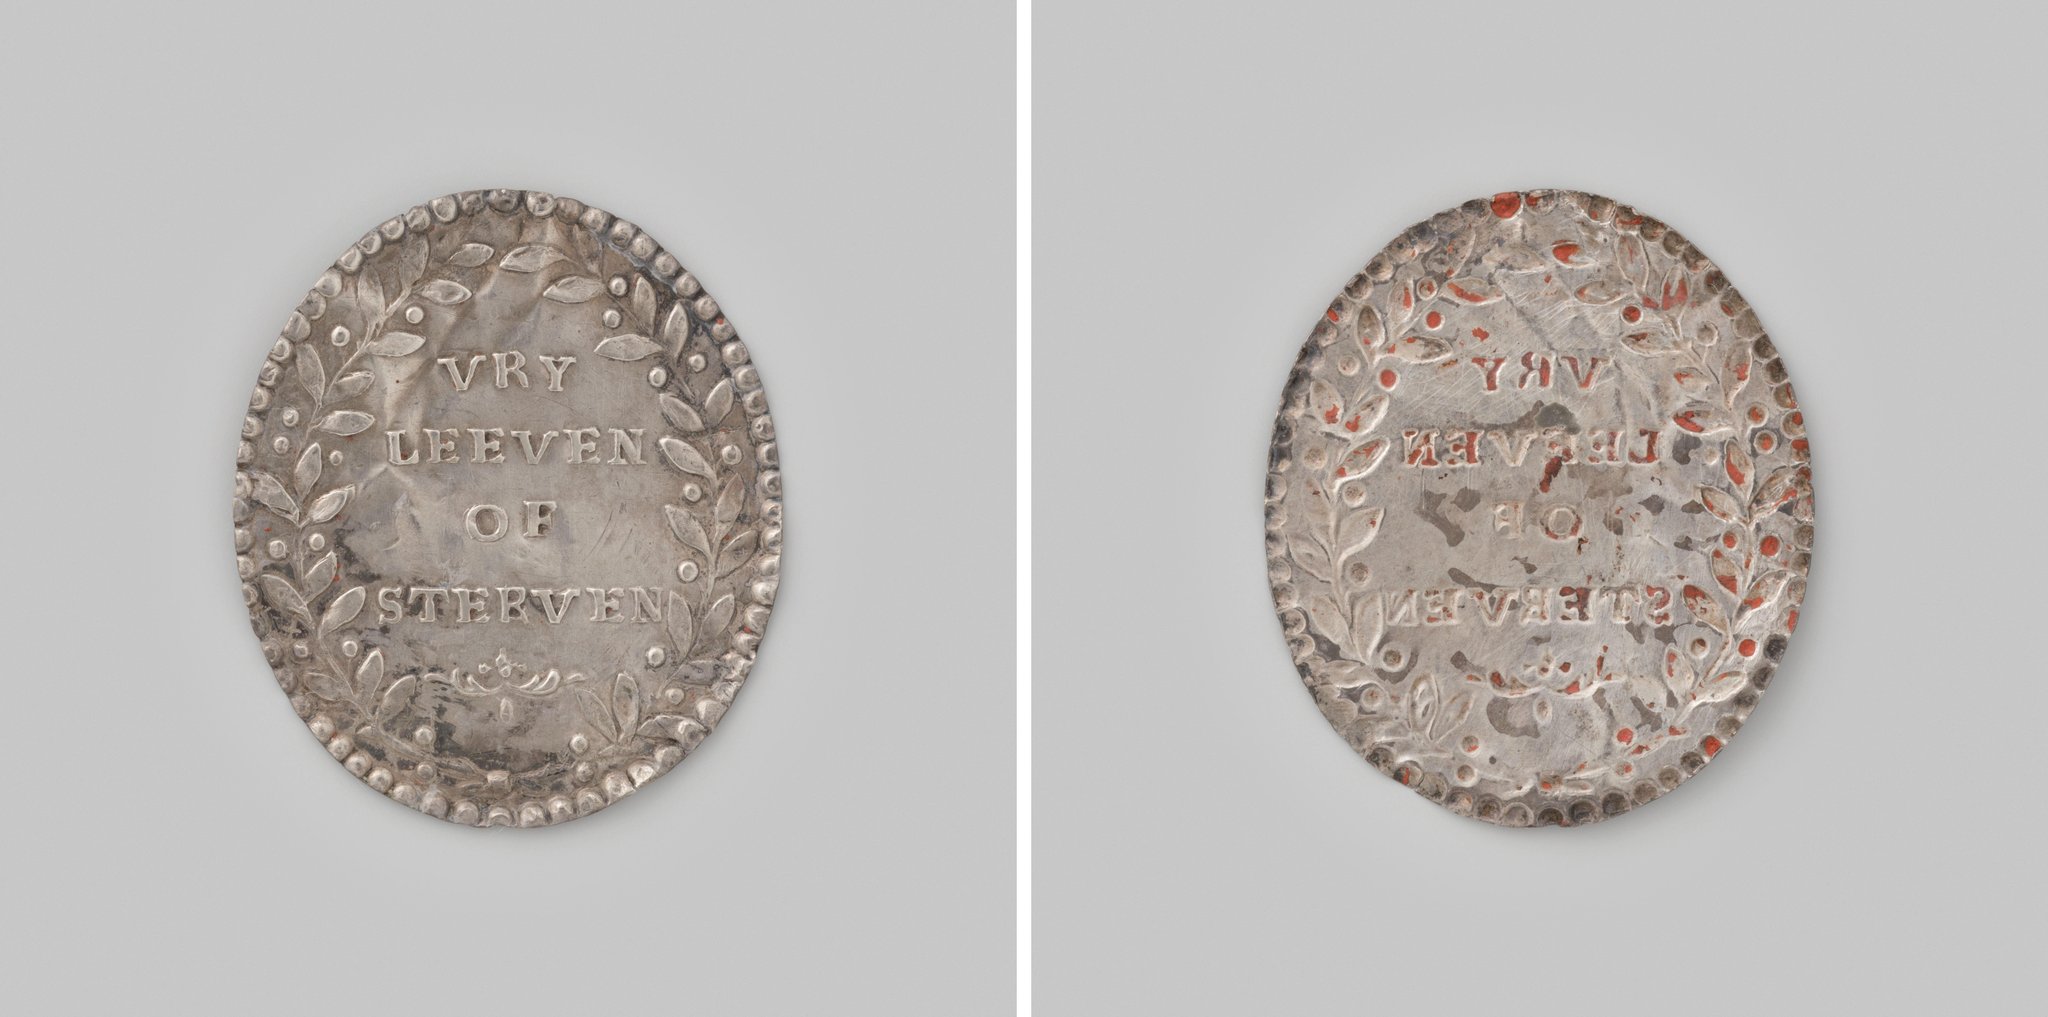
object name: insignia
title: Uitgeweken Nederlandse patriotten die zich in Frankrijk vestigden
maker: Anonymous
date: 1794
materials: silver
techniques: embroidery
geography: netherlands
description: Eenzijdig zilveren ovaal plaatje. Voorzijde: opschrift binnen lauwerkrans en parelrand. Keerzijde: blanco